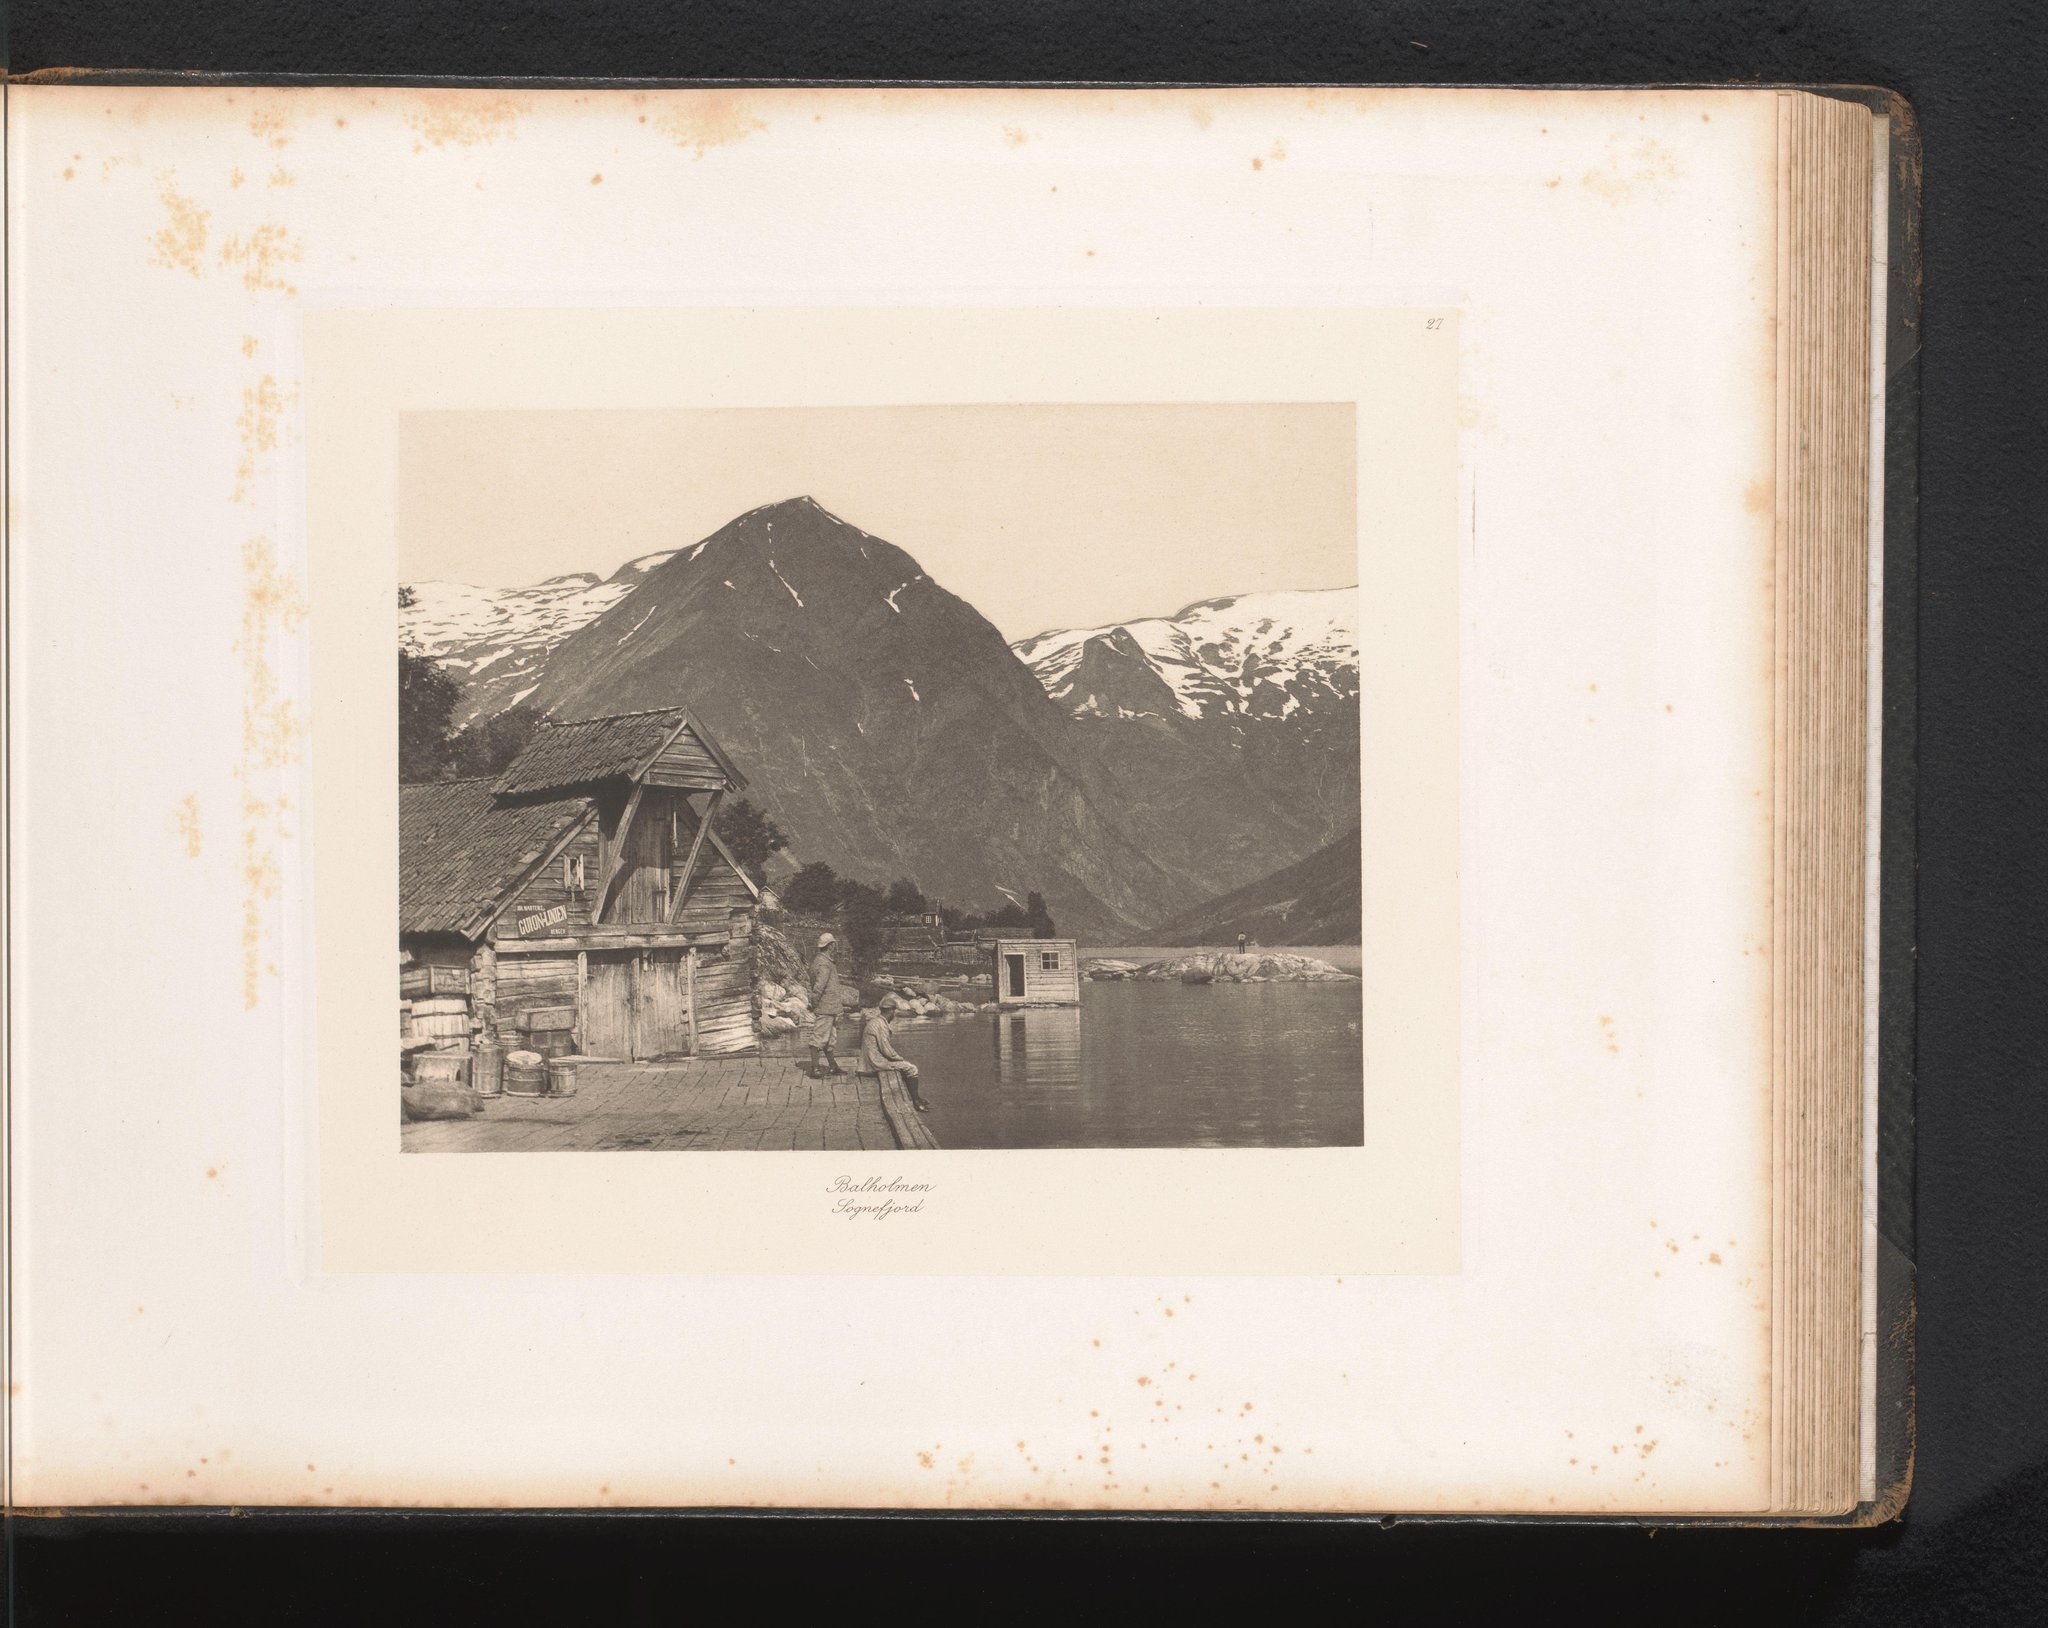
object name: photomechanical print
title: Balholmen, Sognefjord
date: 1888-1893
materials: paper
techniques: photograph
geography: sogn og fjordane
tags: fjord, sea loch, mountains (+ landscape with figures, staffage)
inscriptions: number: ‘27’